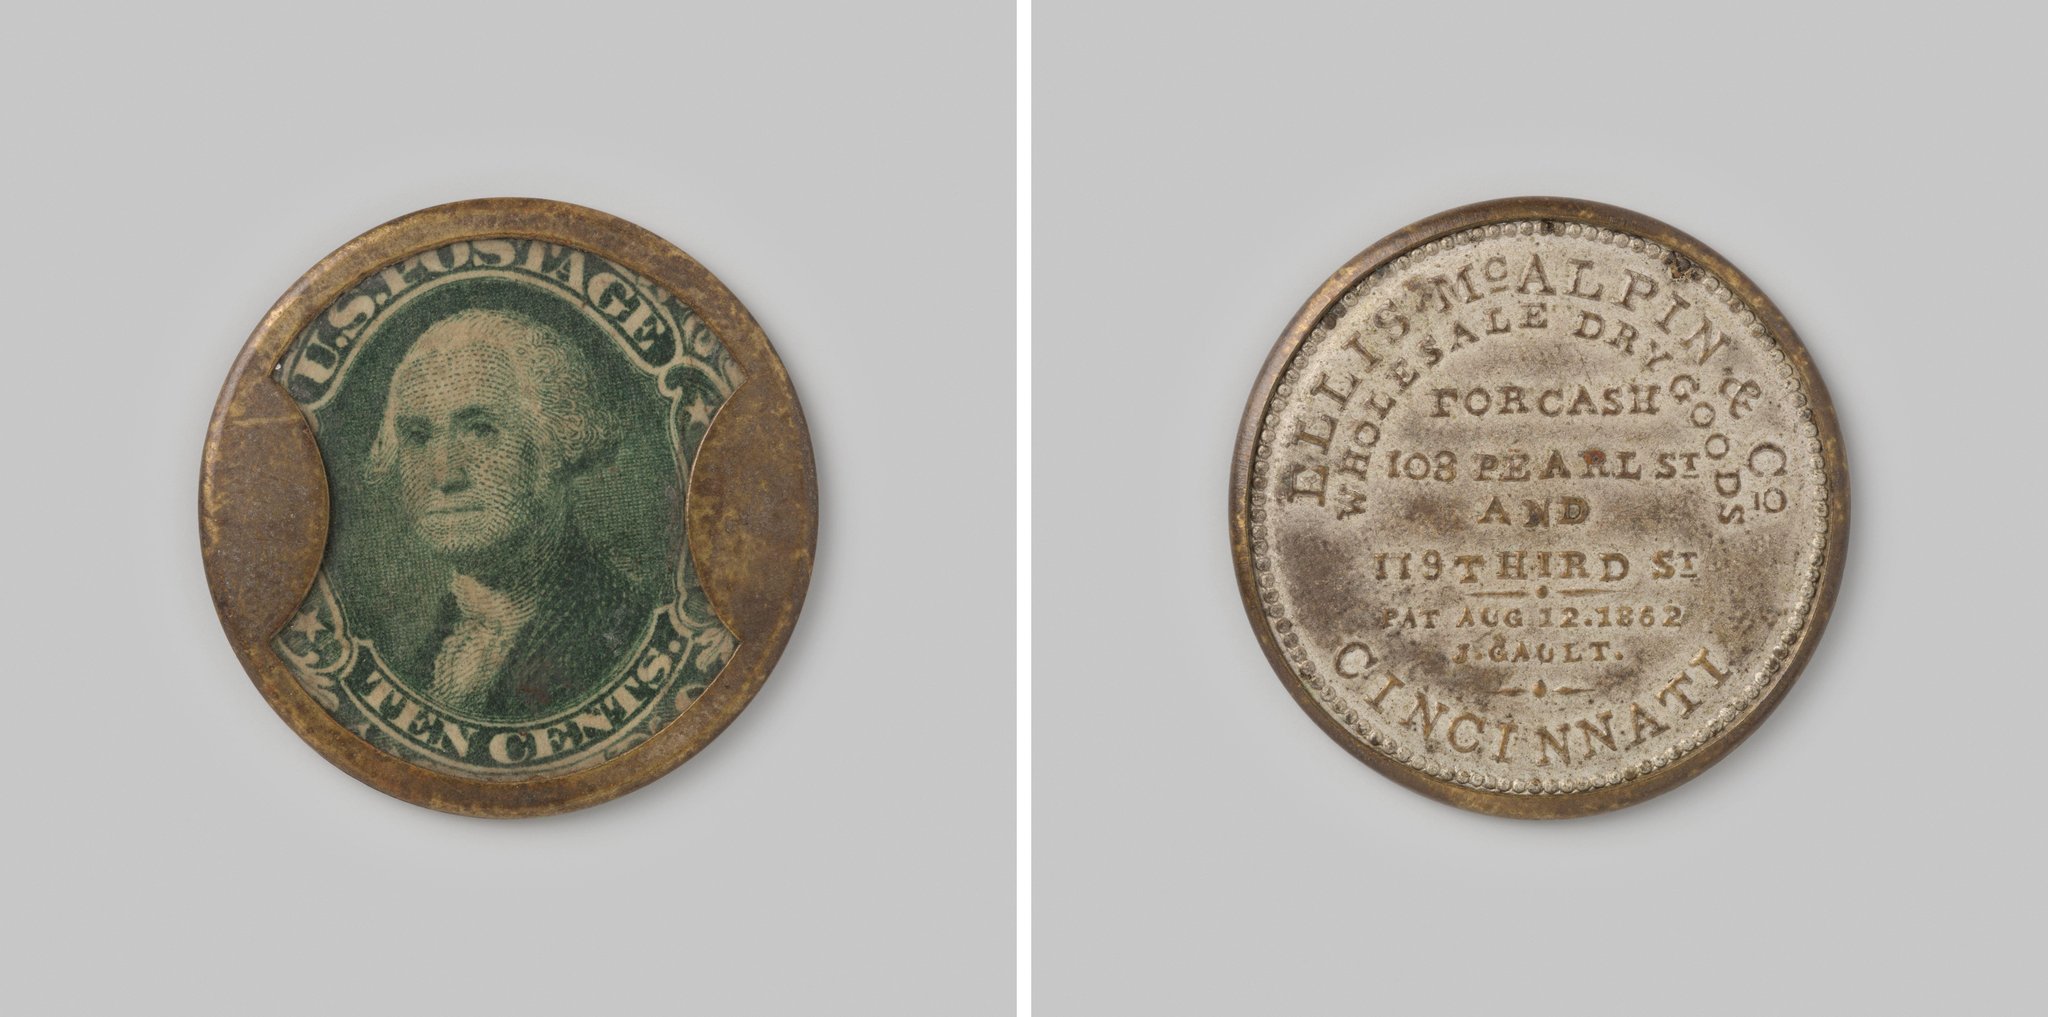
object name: coin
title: Particuliere munt van 10 cents uit Cincinnati in de Verenigde Staten van Amerika, (1862-1863)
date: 1862-1863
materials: nickel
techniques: striking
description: Particuliere munt, een postzegel, gehouden in een koper-nikkelen raamwerk. Voorzijde: onder doorzichtig laagje plastic Amerikaanse postzegel van 10 cents, groen met portret van George Washington [?]. Keerzijde: Als omschrift bovenaan firmanaam: Ellis Mc Alpine & Co en onderaan staats-aanduiding: Cincinnati. Daarbinnen opschrift in zes regels.